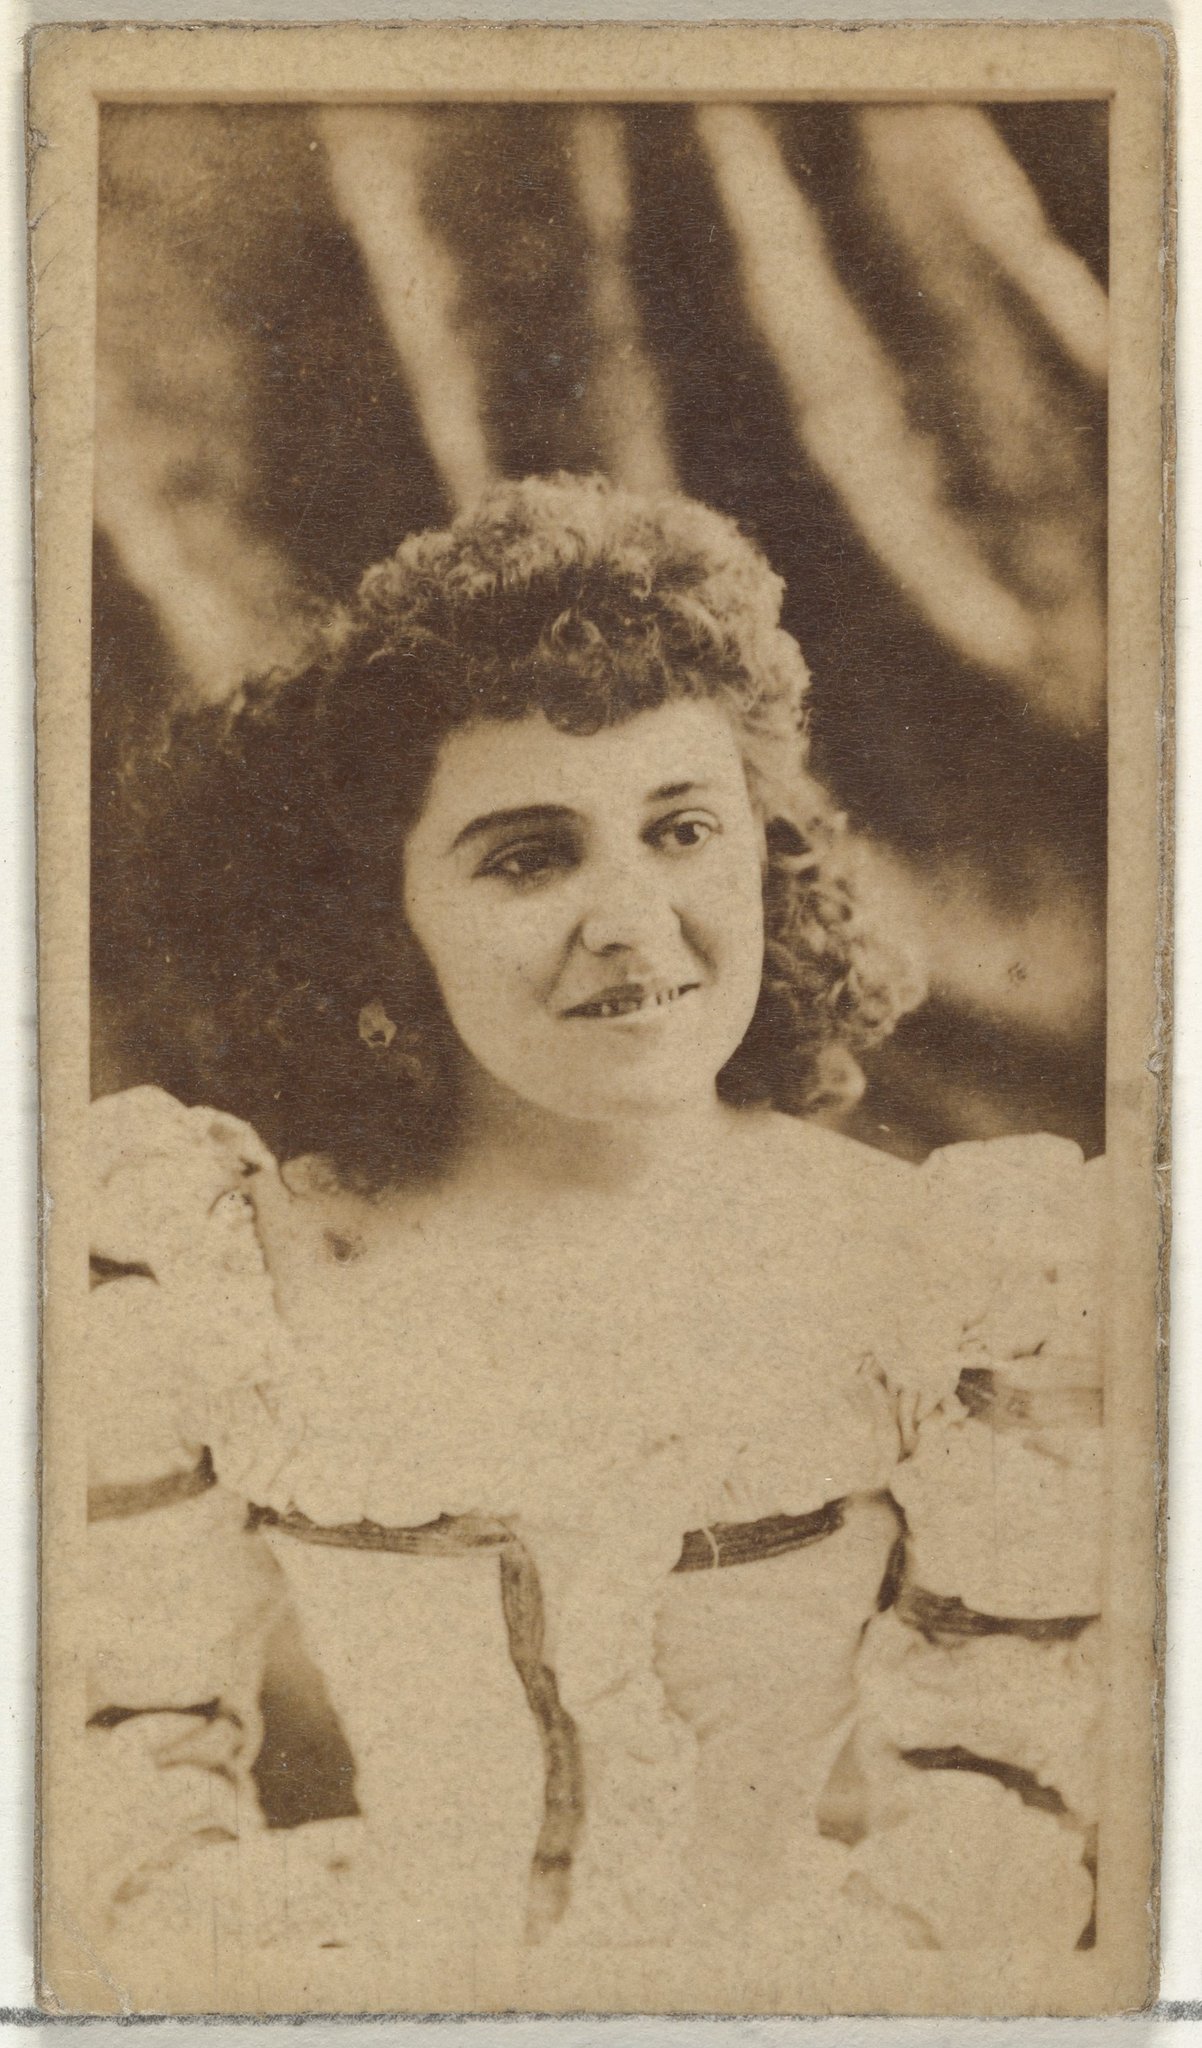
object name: photograph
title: [Actress with curly hair], from the Actors and Actresses series (N145-8) issued by Duke Sons & Co. to promote Duke Cigarettes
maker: w. duke, sons & co.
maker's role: publisher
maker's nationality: american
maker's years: 1870-1920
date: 1891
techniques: albumen silver print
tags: portraits,women,actresses